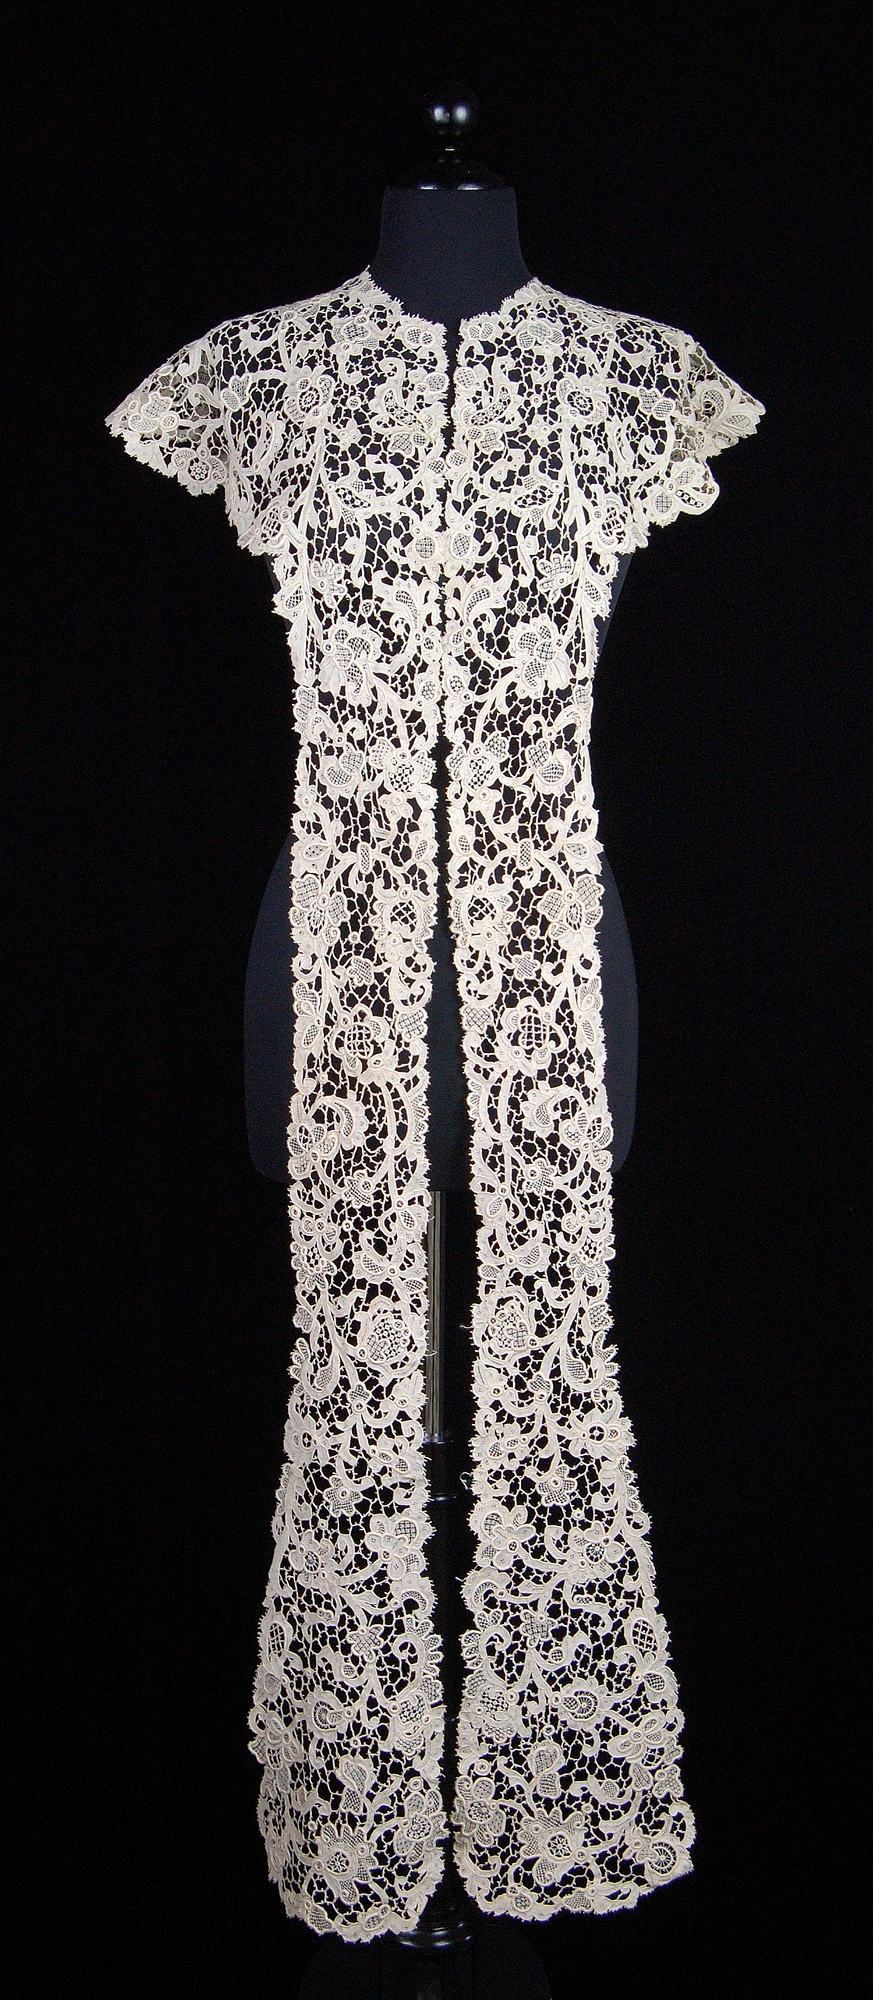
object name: pelerine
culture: italian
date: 1895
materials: linen